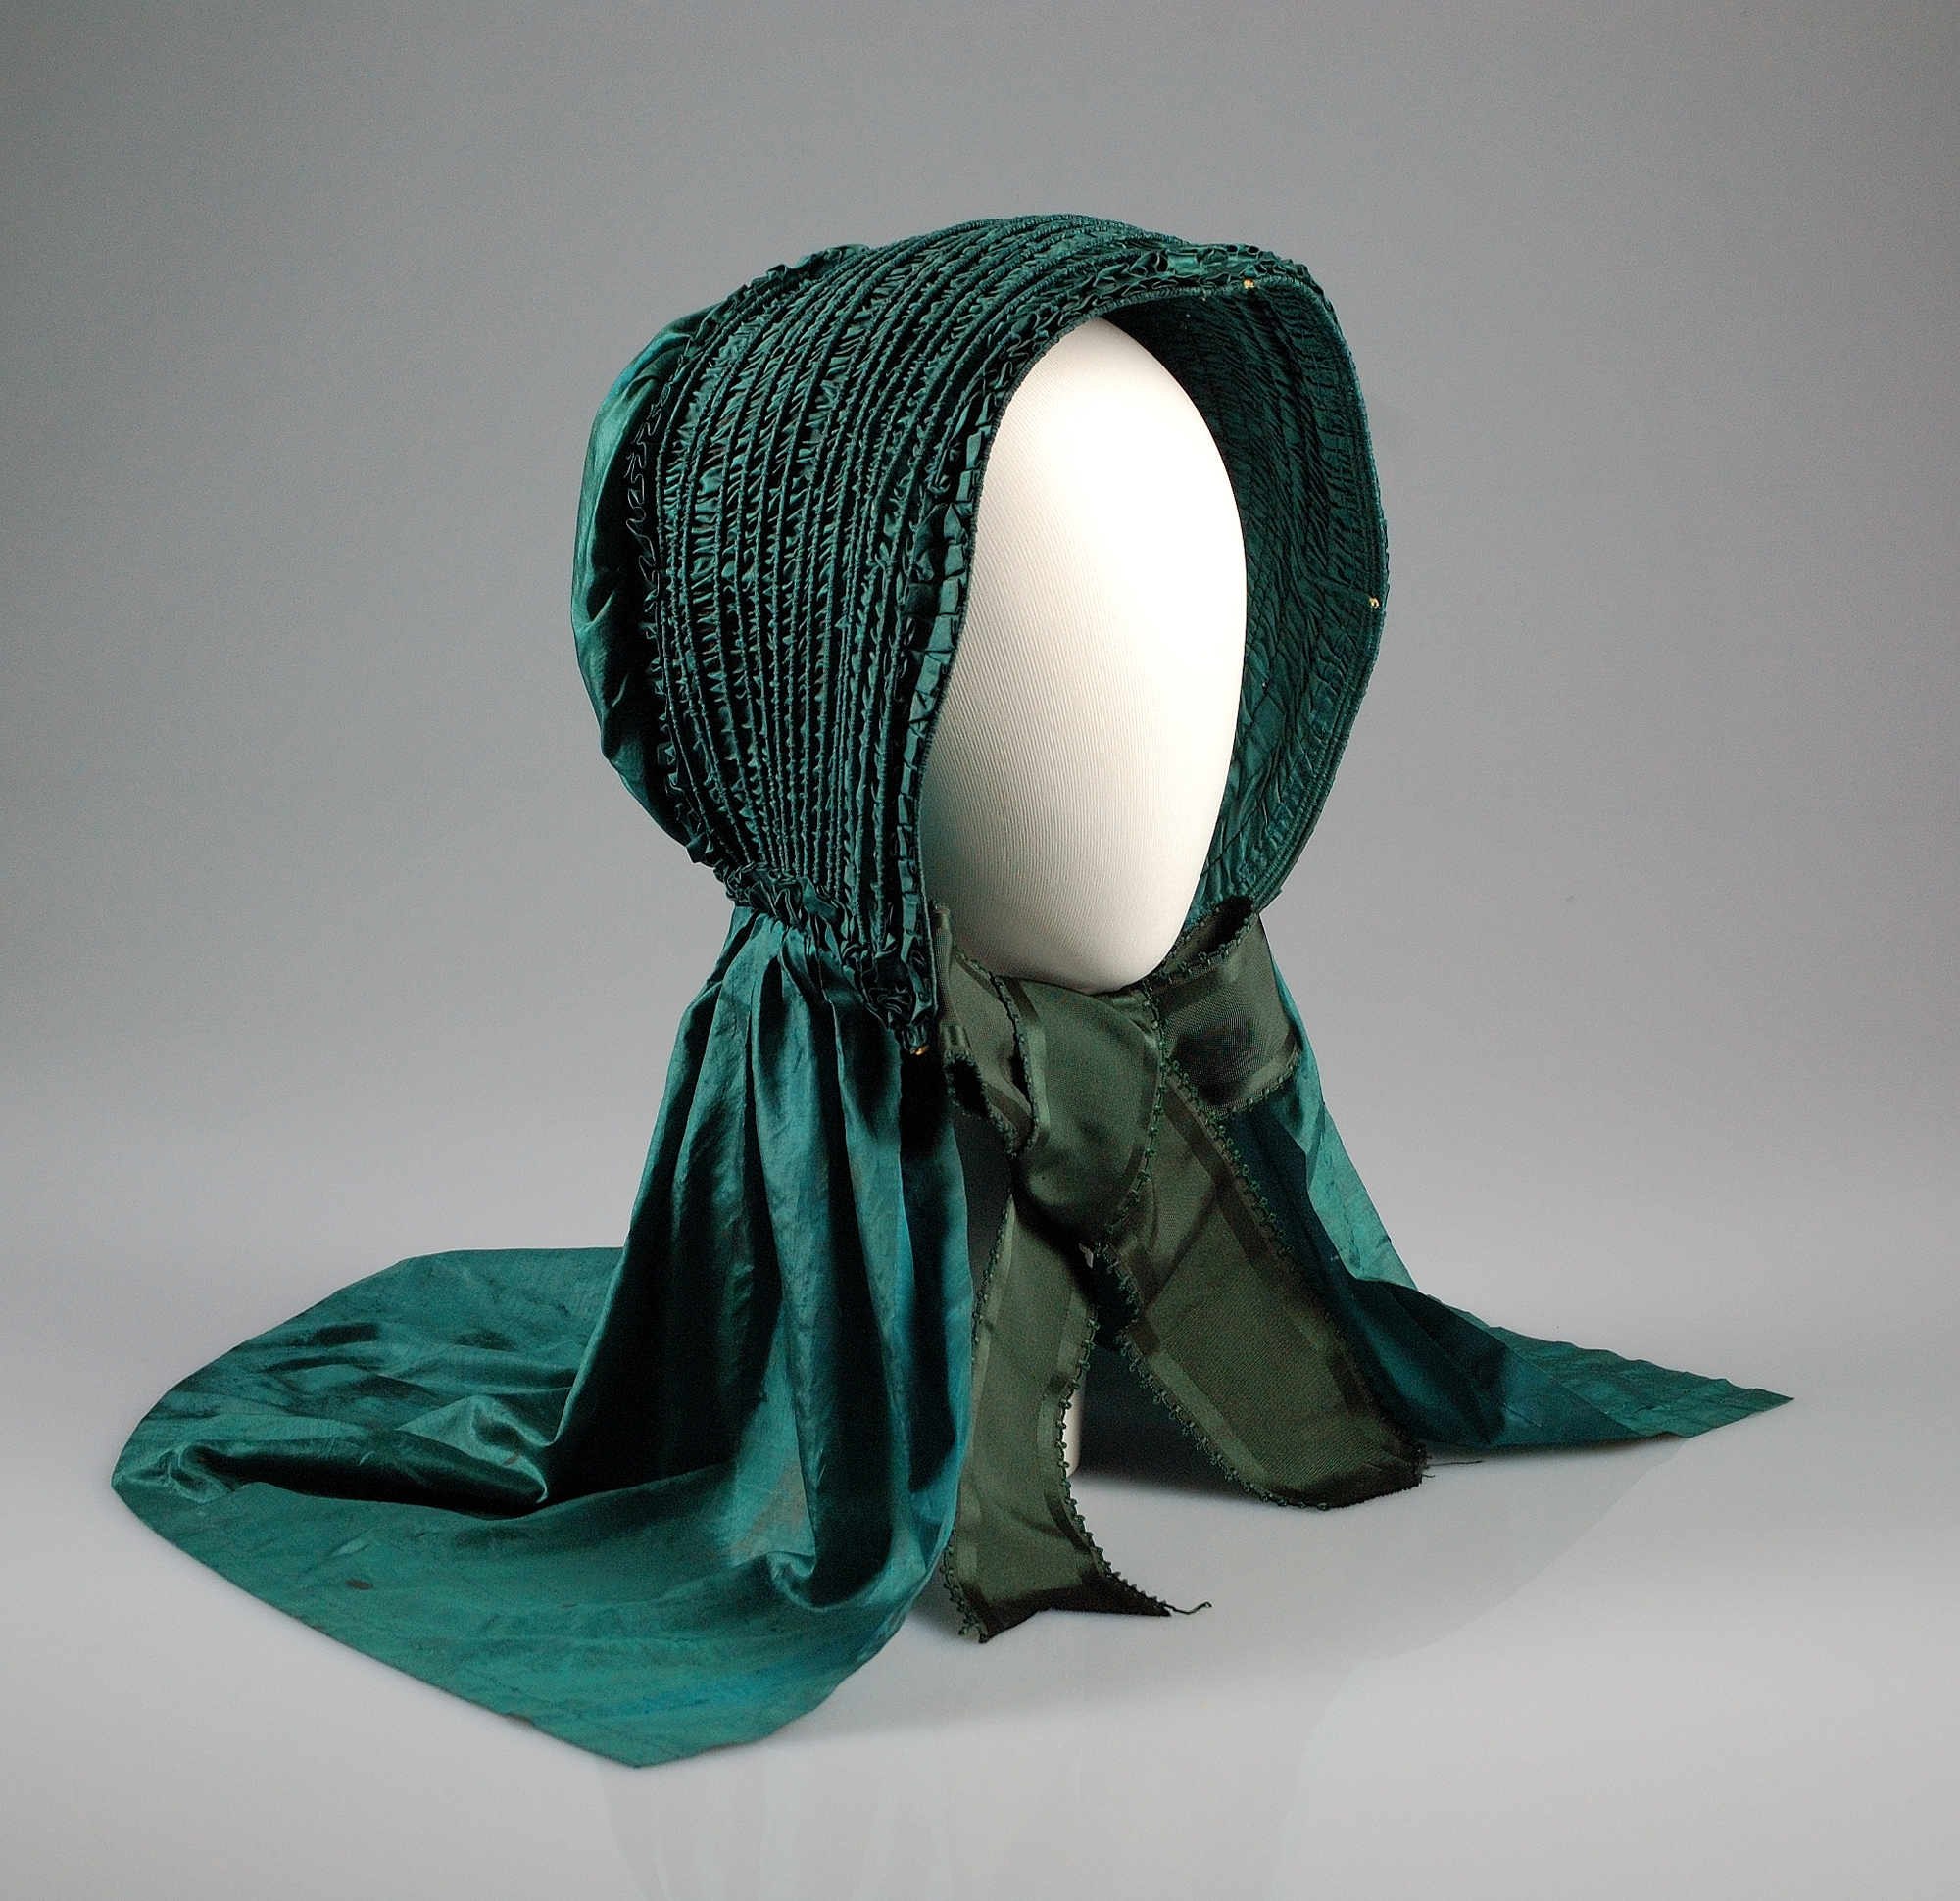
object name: bonnet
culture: american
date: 1845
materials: silk